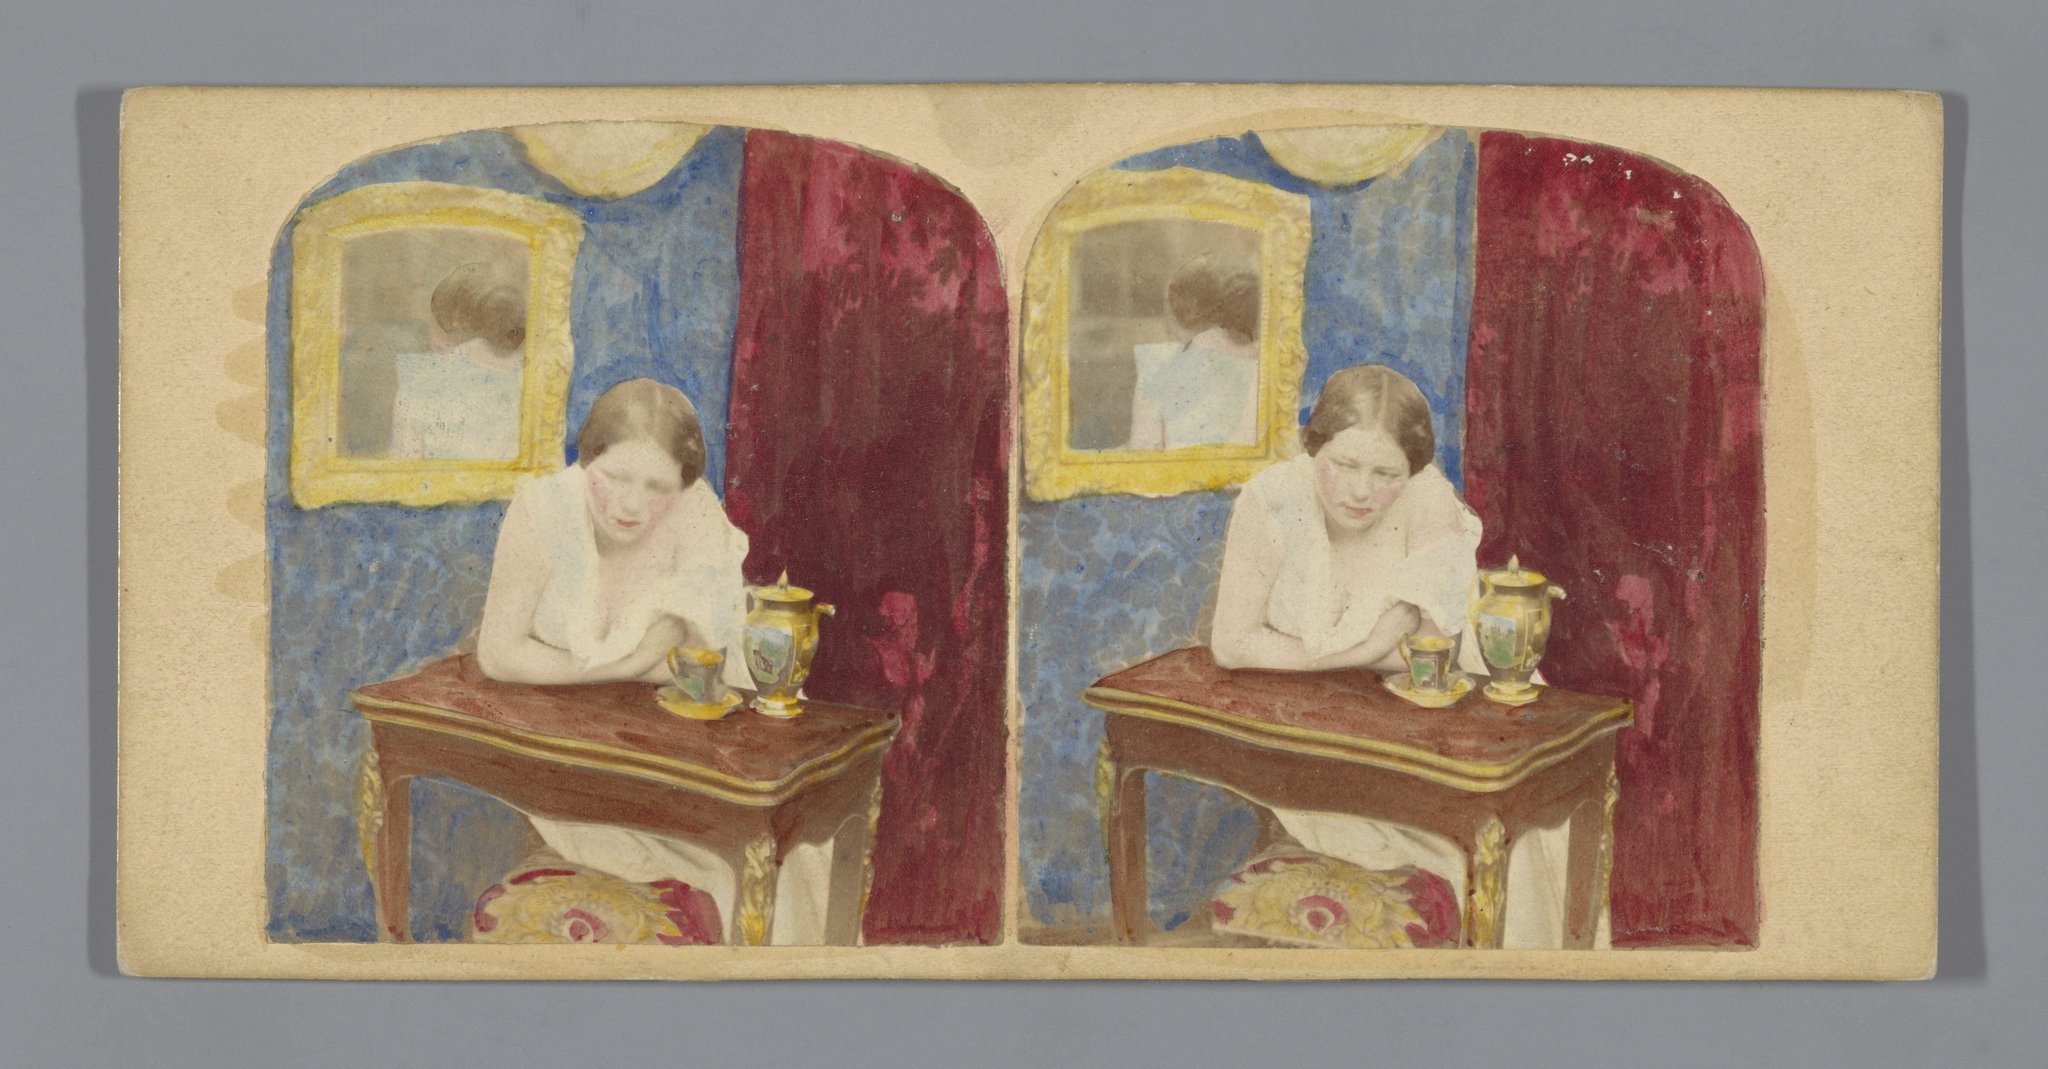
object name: stereograph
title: Tafereel met een vrouw leunend op een tafeltje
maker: Anonymous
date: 1852-1858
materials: cardboard, paper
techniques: albumen print, hand coloring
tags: adult woman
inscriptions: inscription: ‘ae 50’